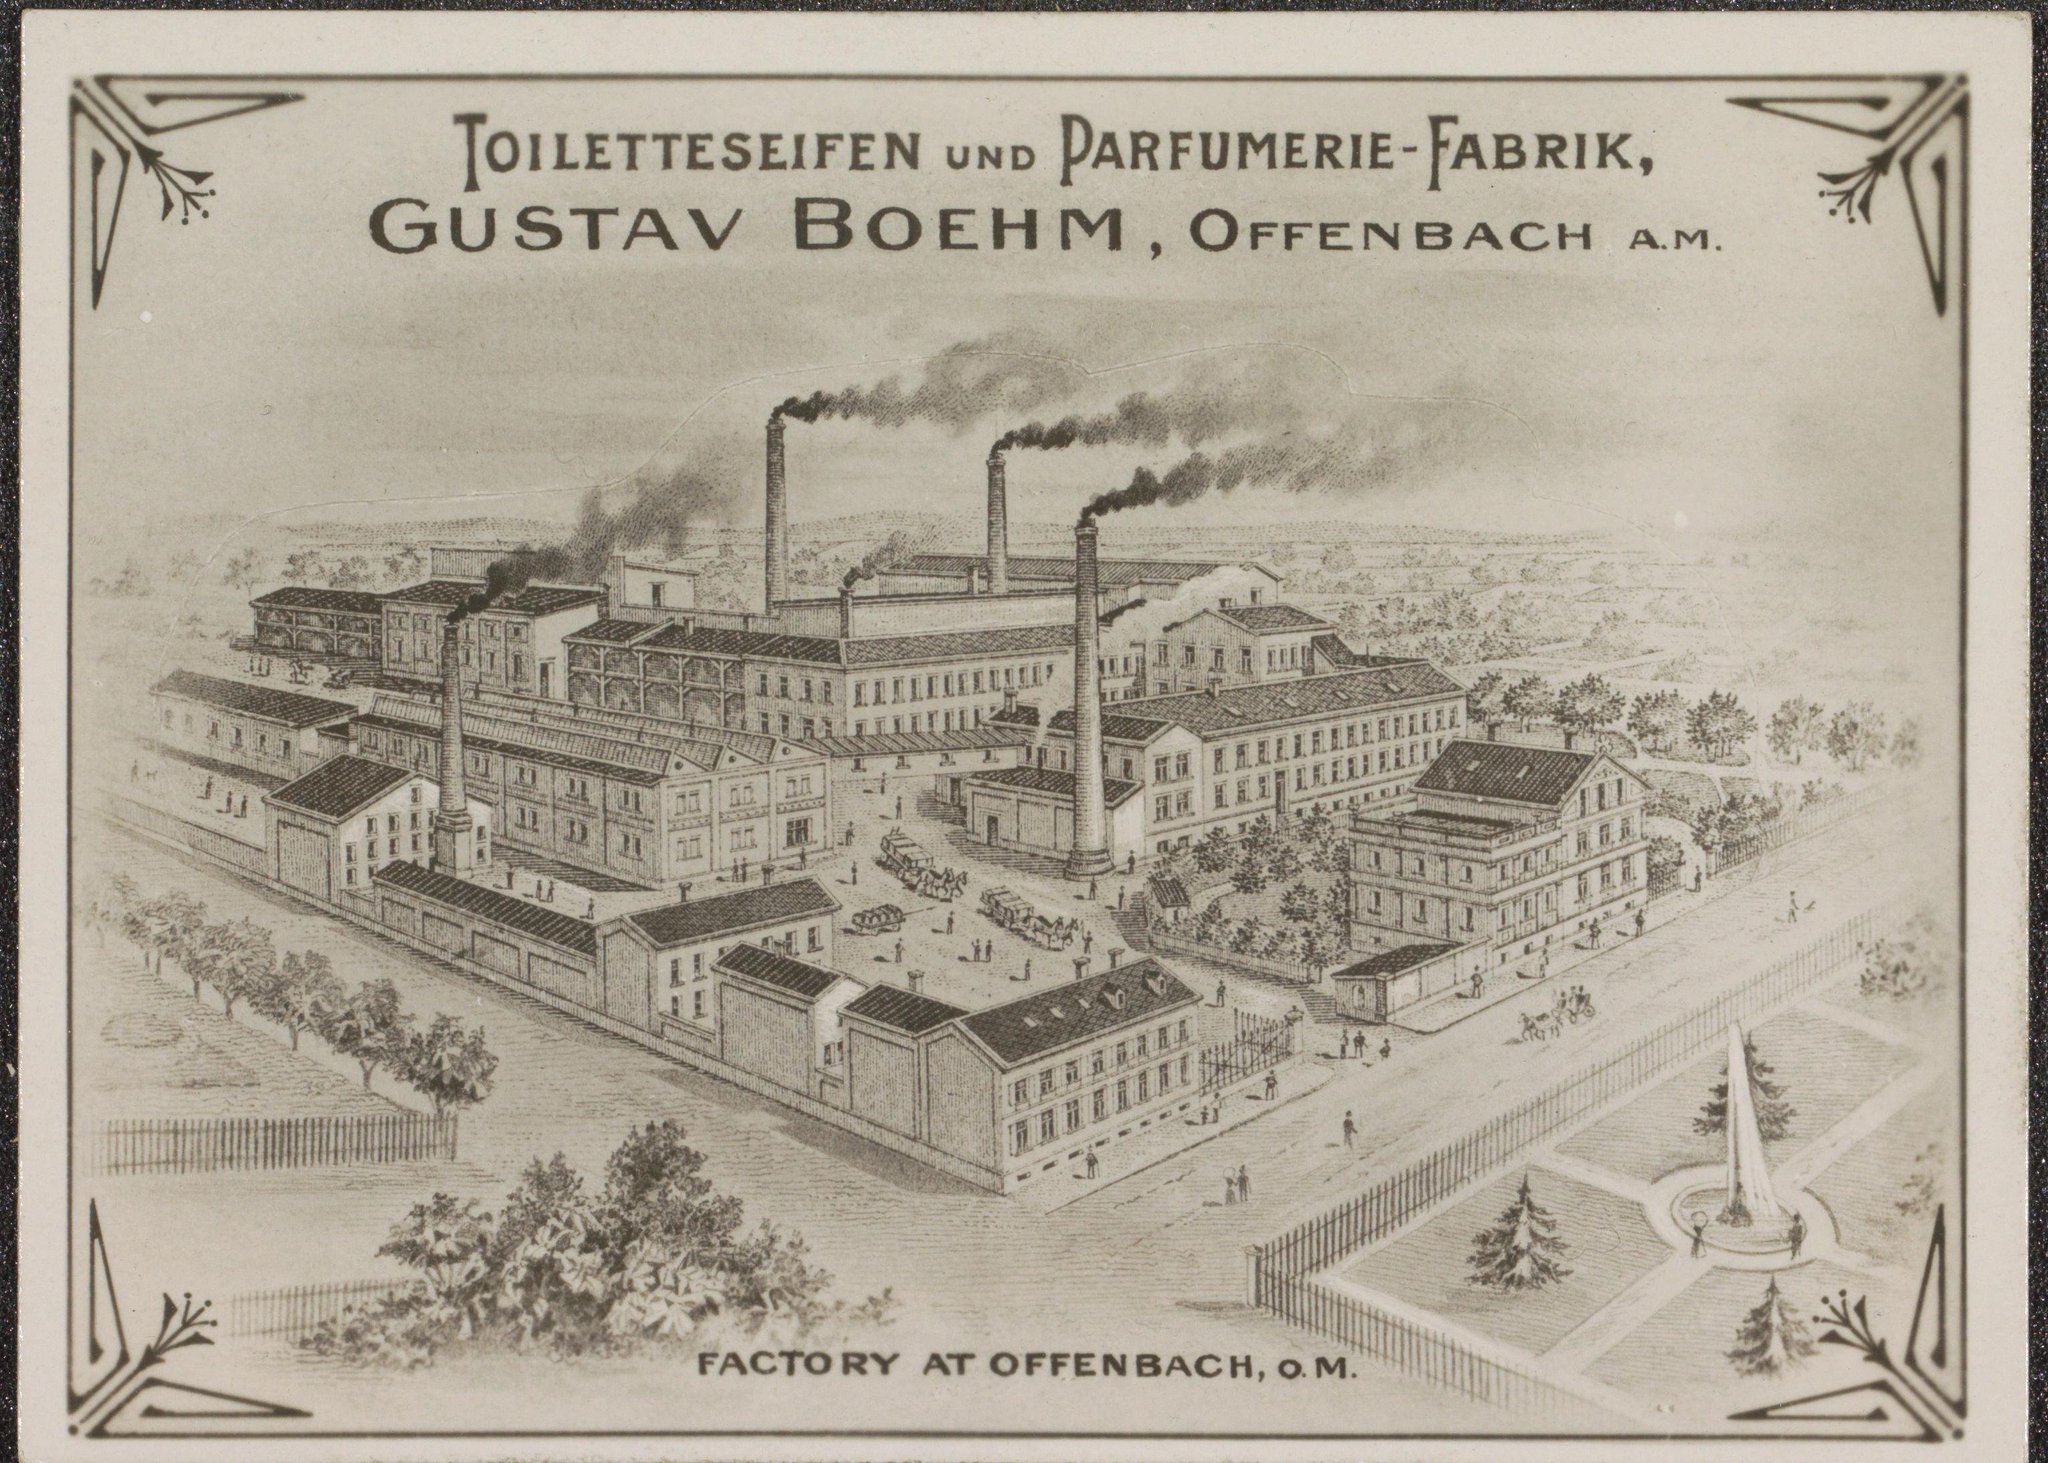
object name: reproduction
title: Fotoreproductie van (vermoedelijk) een prent van de zeep- en reukwerkfabriek van Gustav Boehm in Offenbach am Main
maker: Anonymous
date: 1899-1901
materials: paper, photographic support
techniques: gelatin silver print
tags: factory-building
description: Onderdeel van Foto's van de wereldreis van Gustav Boehm 1899-1901, serie 2.